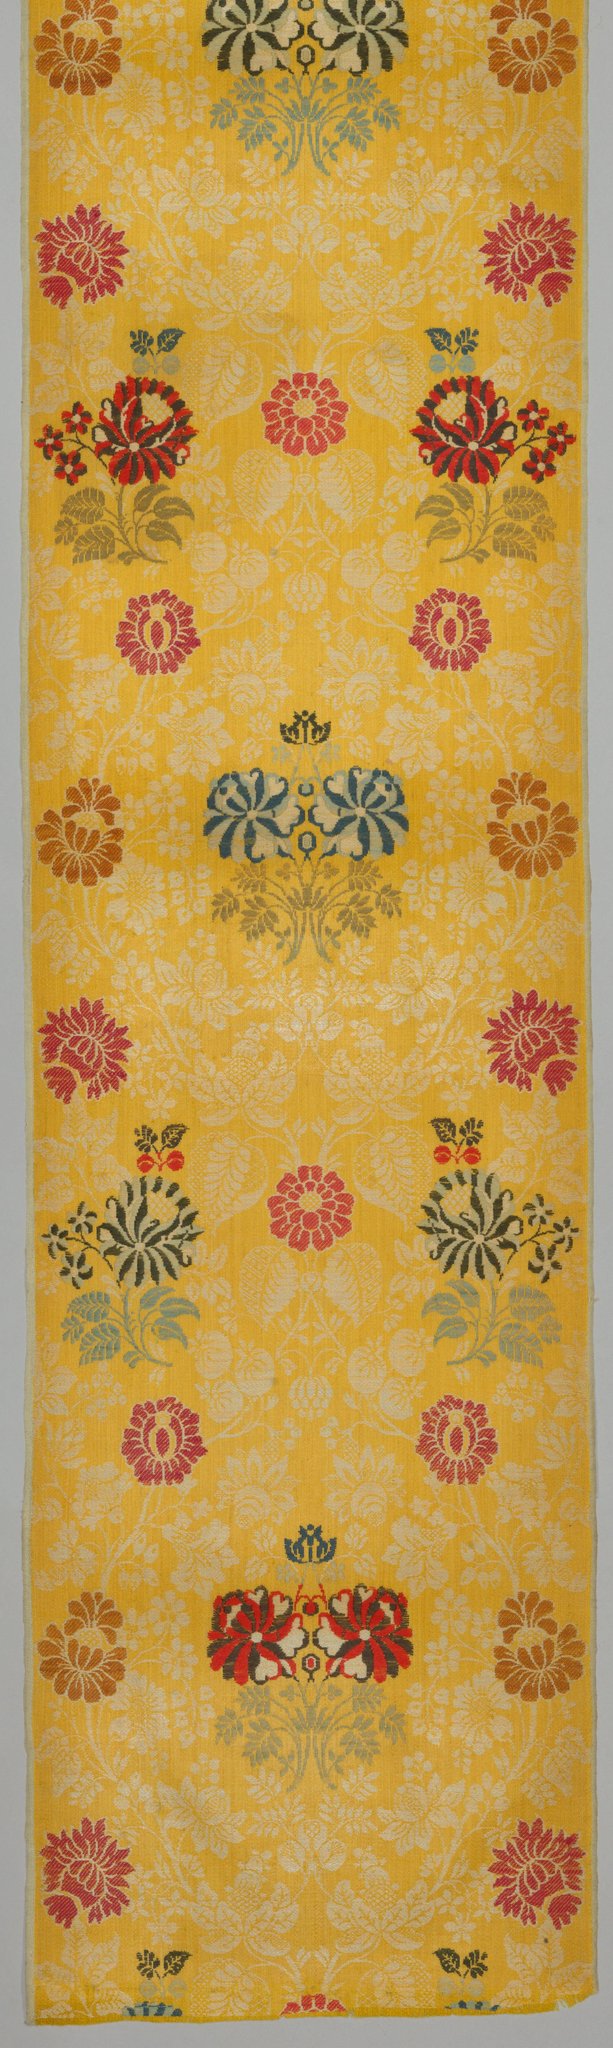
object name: woven material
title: Weefsel van wollen grein, veelkleurige bloemen op een gele fond met een patoon van takken, bladeren en bloemen in wit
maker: Anonymous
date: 1750-1760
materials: wool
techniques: brocade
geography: norwich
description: Veelkleurige bloemen op een gele fond met een patoon van takken, bladeren en bloemen in wit. Kamgaren broché, wol, grein.